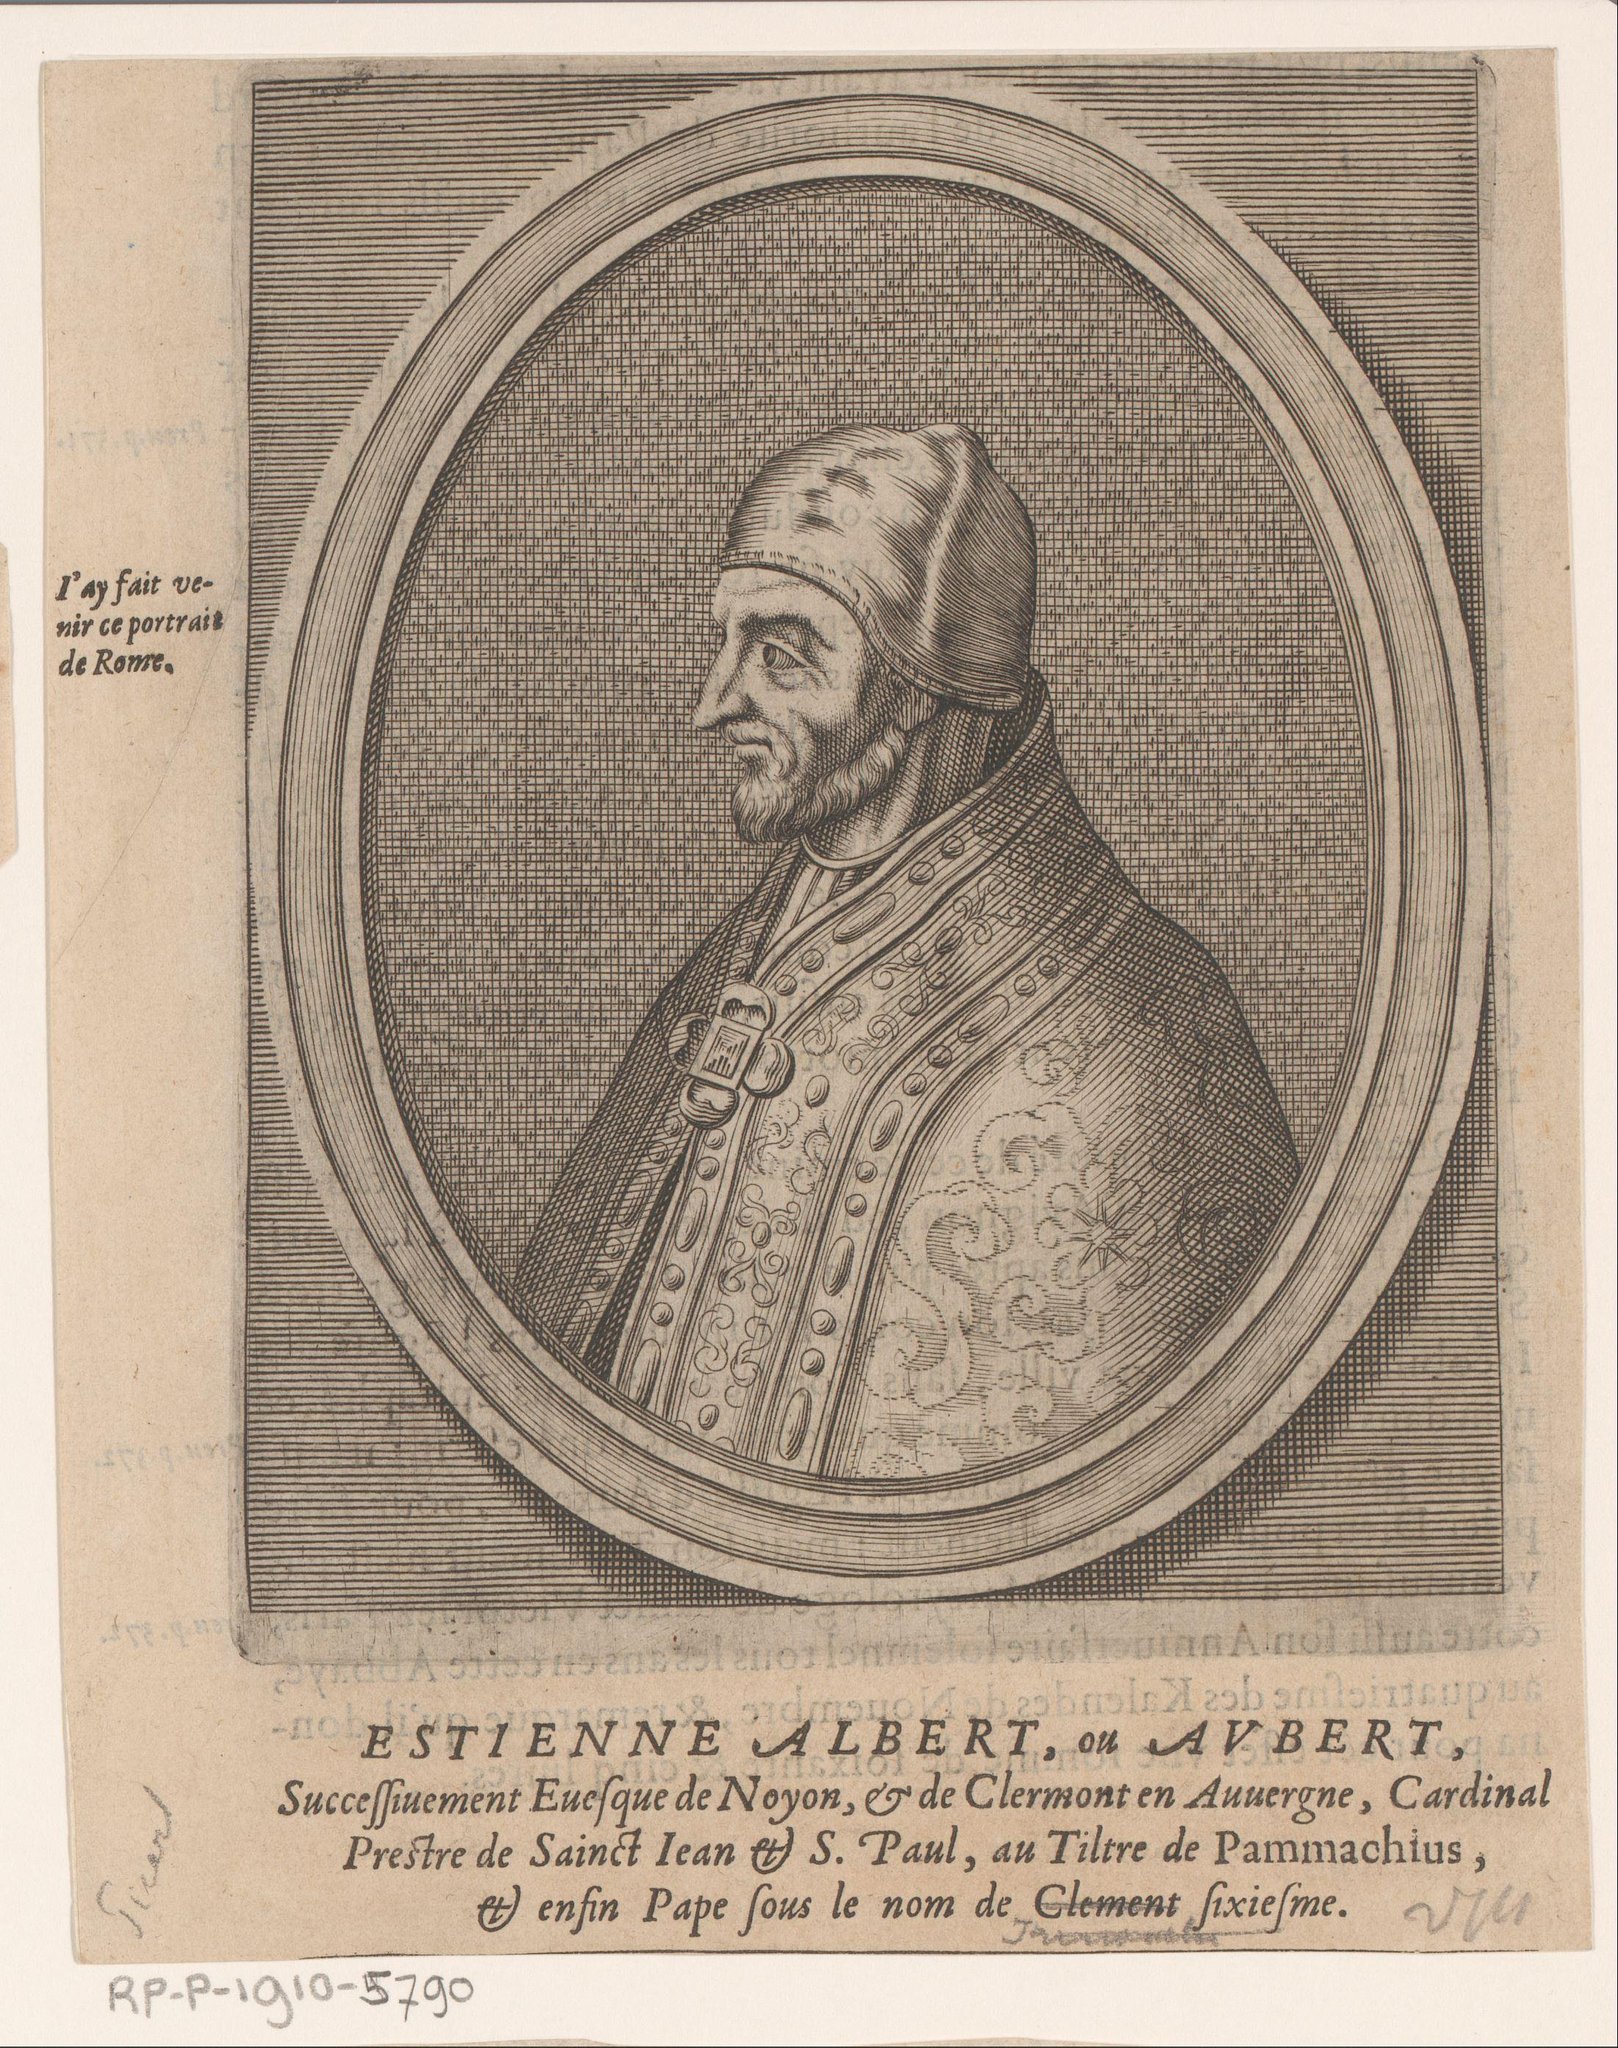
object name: print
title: Estienne Albert, ou Aubert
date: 1660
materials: paper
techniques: engraving, etching, letterpress printing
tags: historical persons, pope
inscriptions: collector's mark: Lugt 2228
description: Prent uit: Du Chesne, François. Histoire de tous les cardinaux françois de naissance, ou qui ont esté promeus au cardinalat. Parijs: François Du Chesne, 1660.